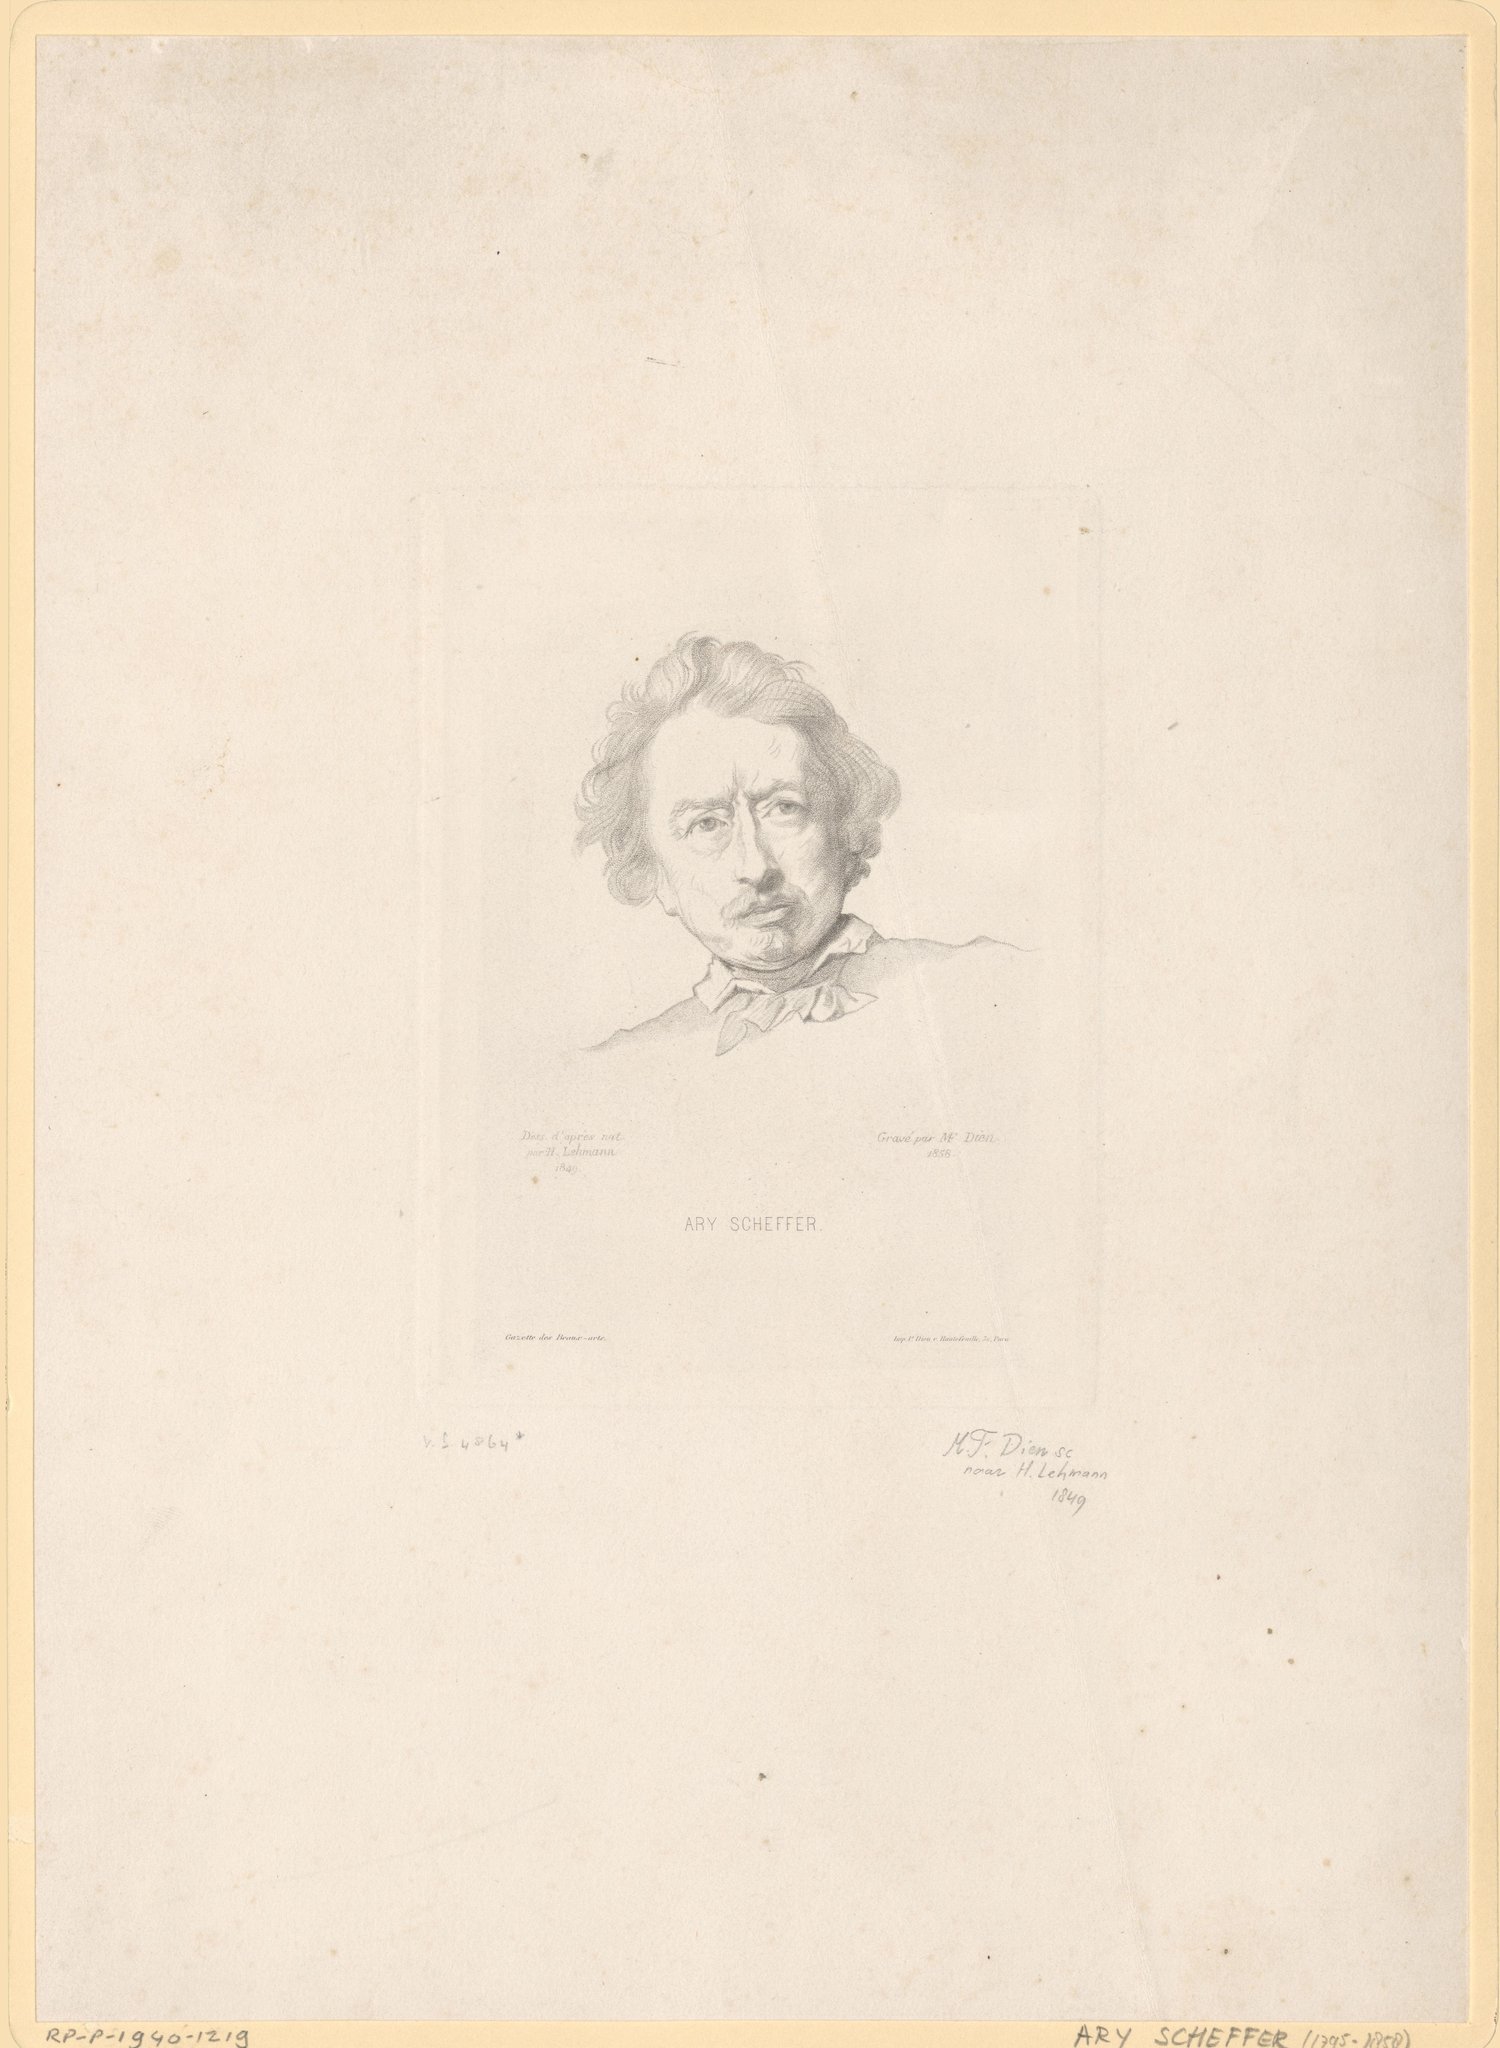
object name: print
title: Portret van Ary Scheffer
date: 1858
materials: paper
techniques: stippling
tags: dordrecht, draughtsman, sculptor, ary scheffer, historical persons, portrait, self-portrait of painter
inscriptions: collector's mark: Lugt 2228, collector's mark: Lugt 2760